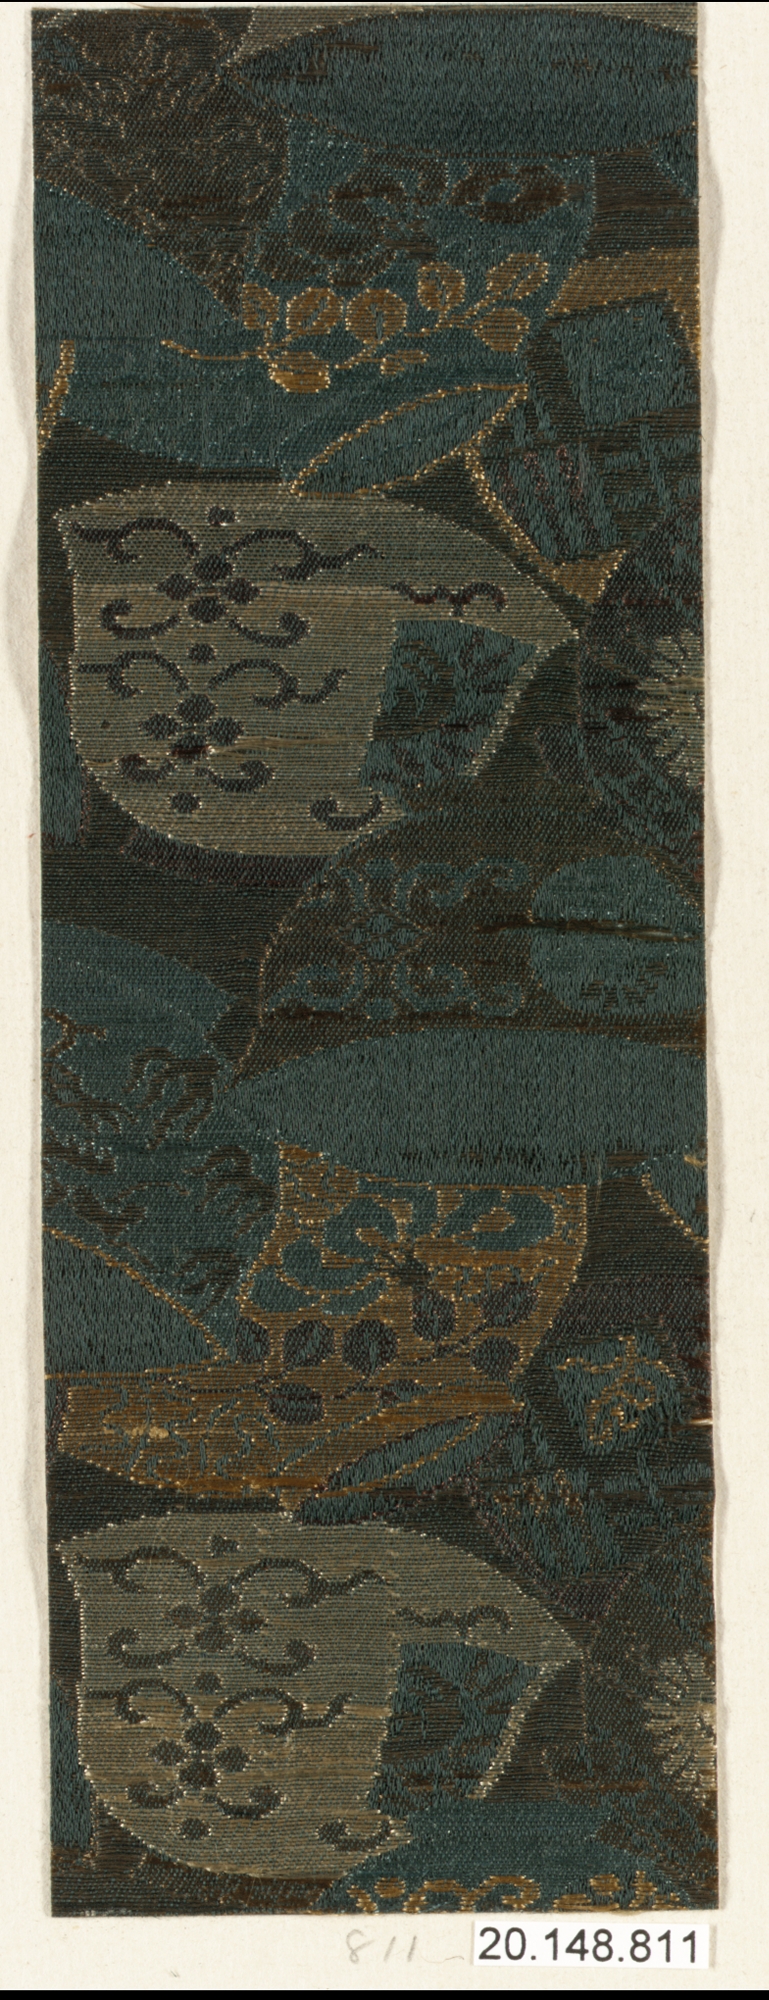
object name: piece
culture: japanese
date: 1701-1800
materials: silk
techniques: compound weave